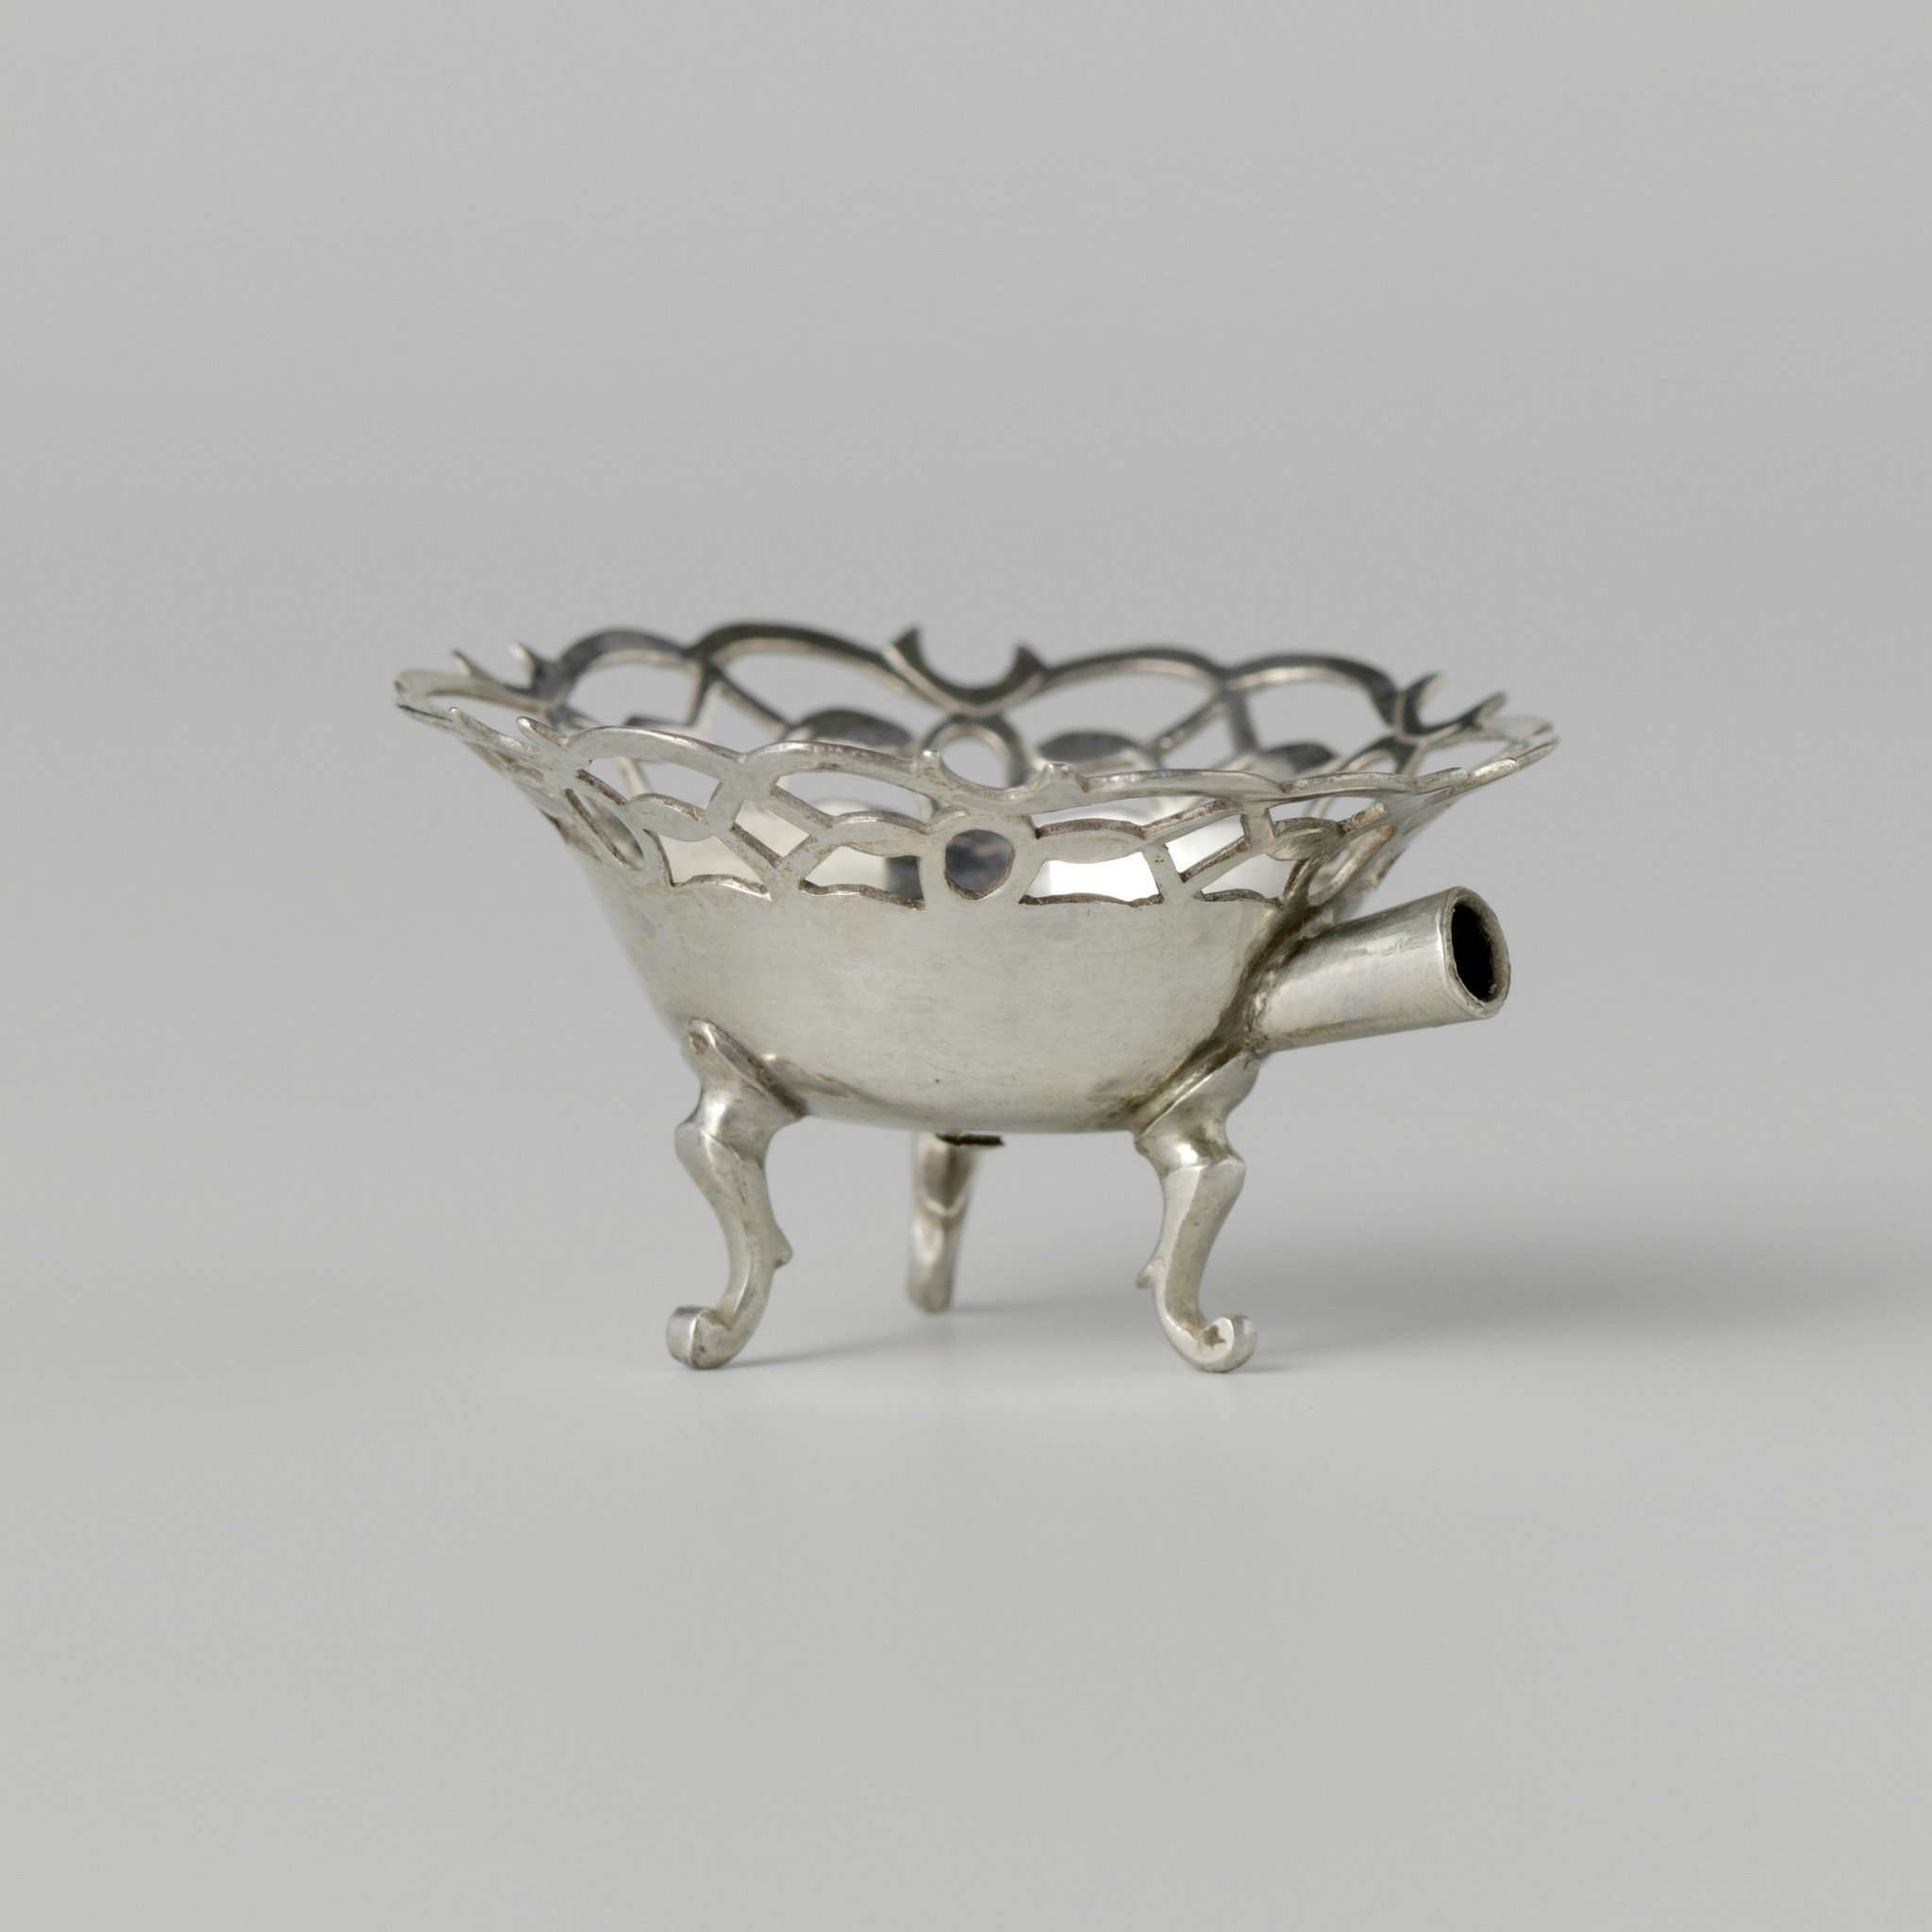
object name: miniature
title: Pijpenkomfoor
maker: Anonymous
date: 1780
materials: copper, silver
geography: amsterdam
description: Rond pijpenkomfoor op drie poten en een aanzet voor een steel. De steel ontbreekt. De bak is wijd klokvormig en heeft een brede opengewerkte rand. In de bak zit een koperen binnenbak. Het komfoor is gemerkt: stk.= Amsterdam, jrl.= V (1780) en een onbekend meesterteken. Het komfoor is gelijk aan een komfoor met invnr. Bk-NM-11177-147.